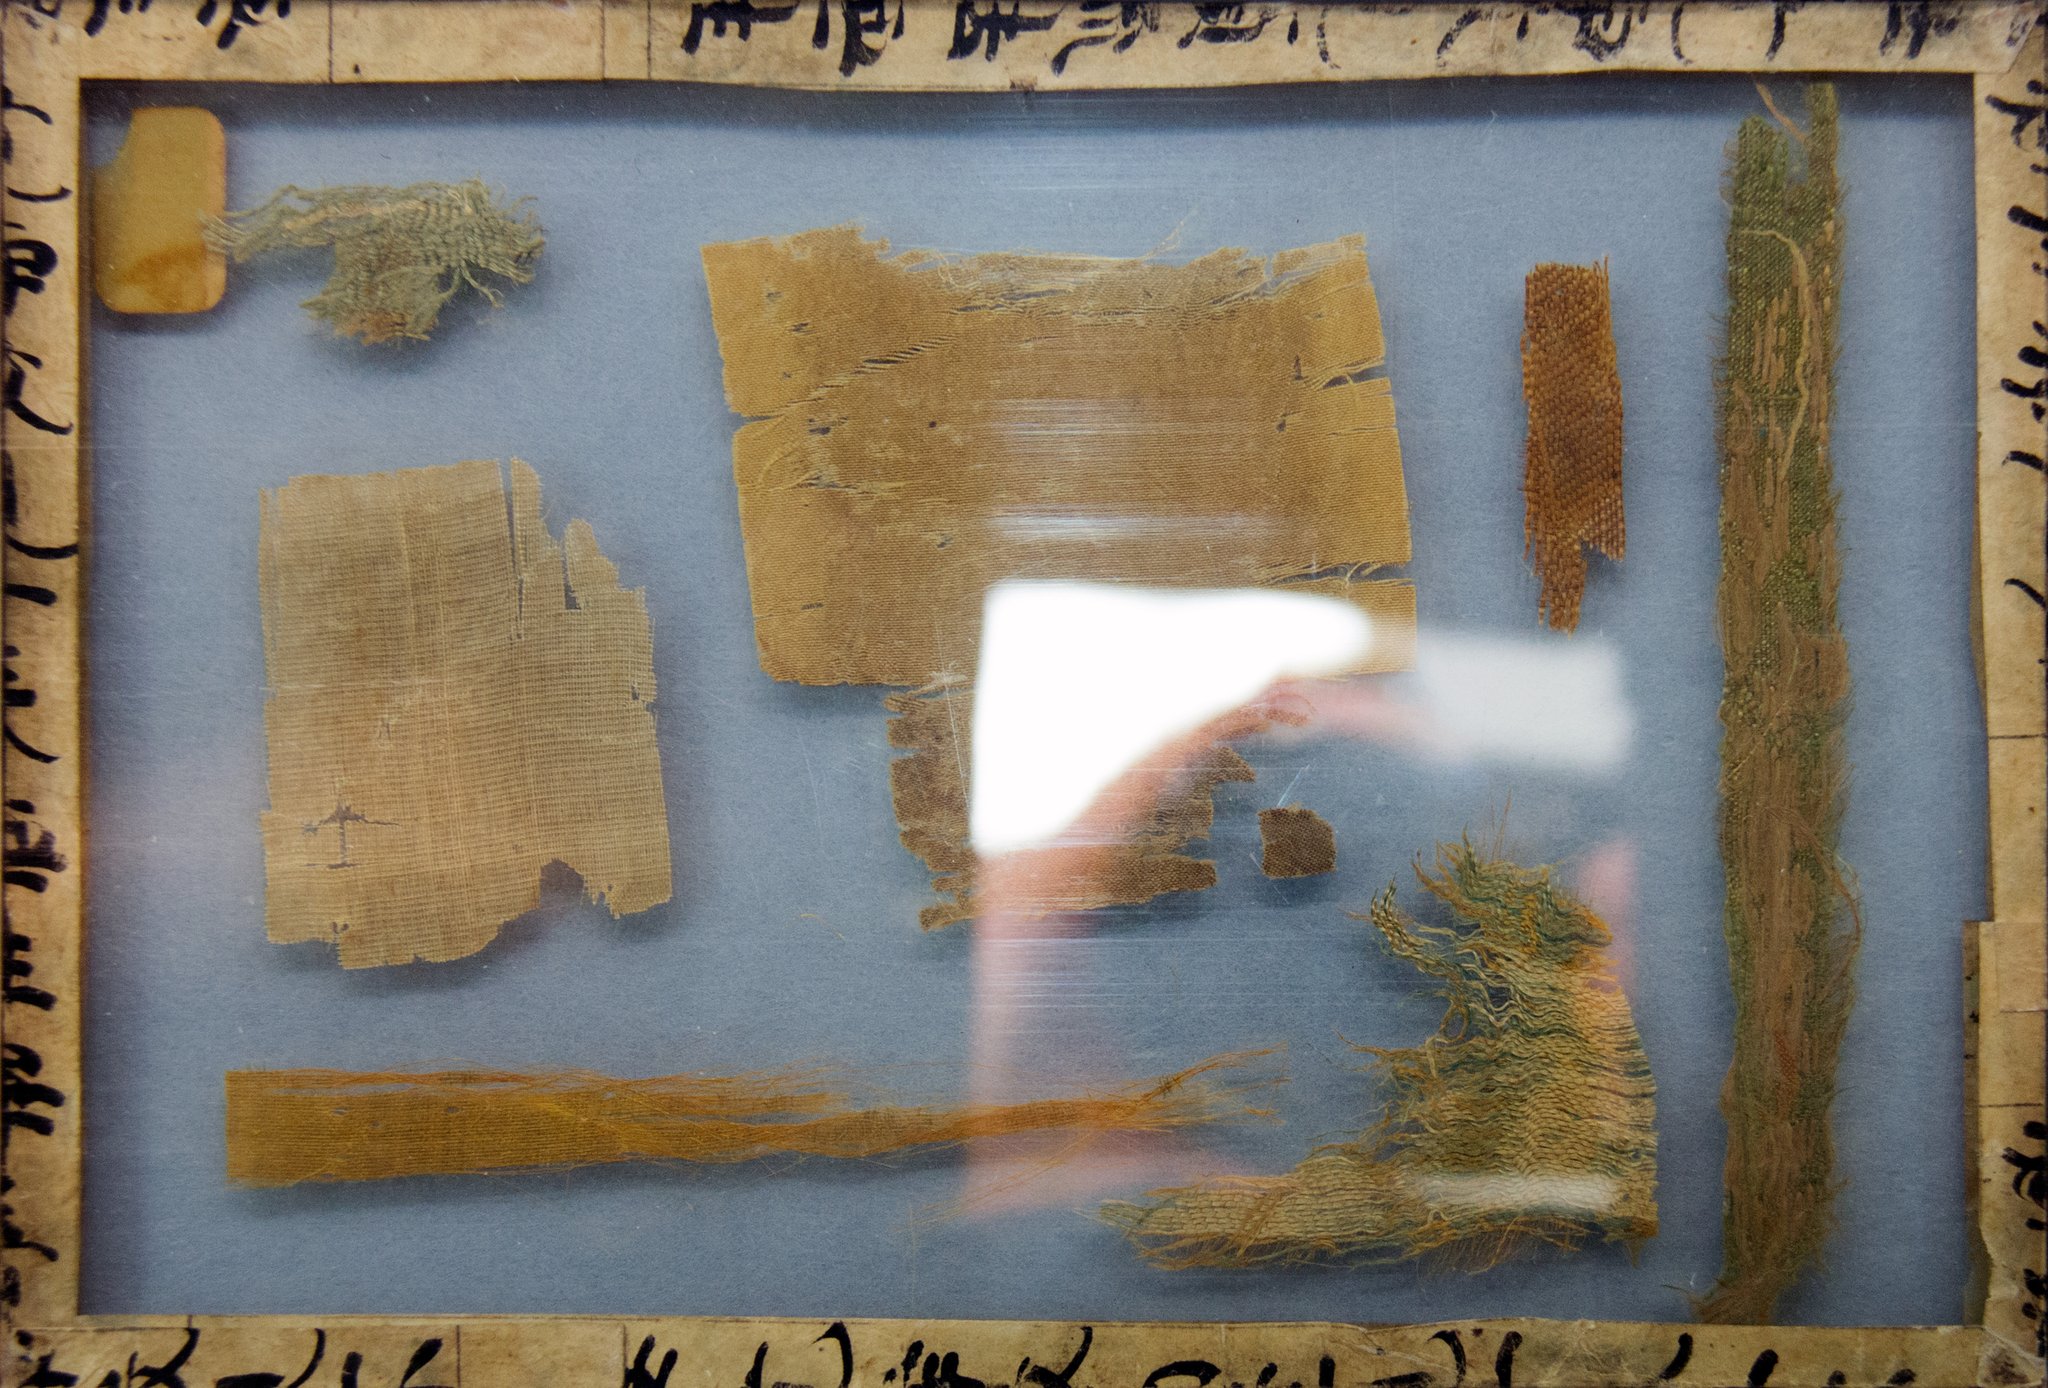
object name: fragment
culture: japanese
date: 701-800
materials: cotton, linen, silk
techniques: weave